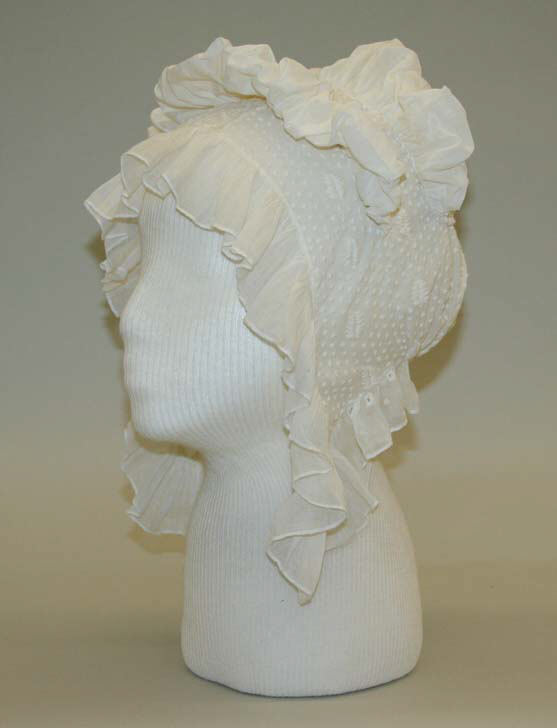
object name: cap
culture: american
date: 1810-1819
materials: cotton, linen